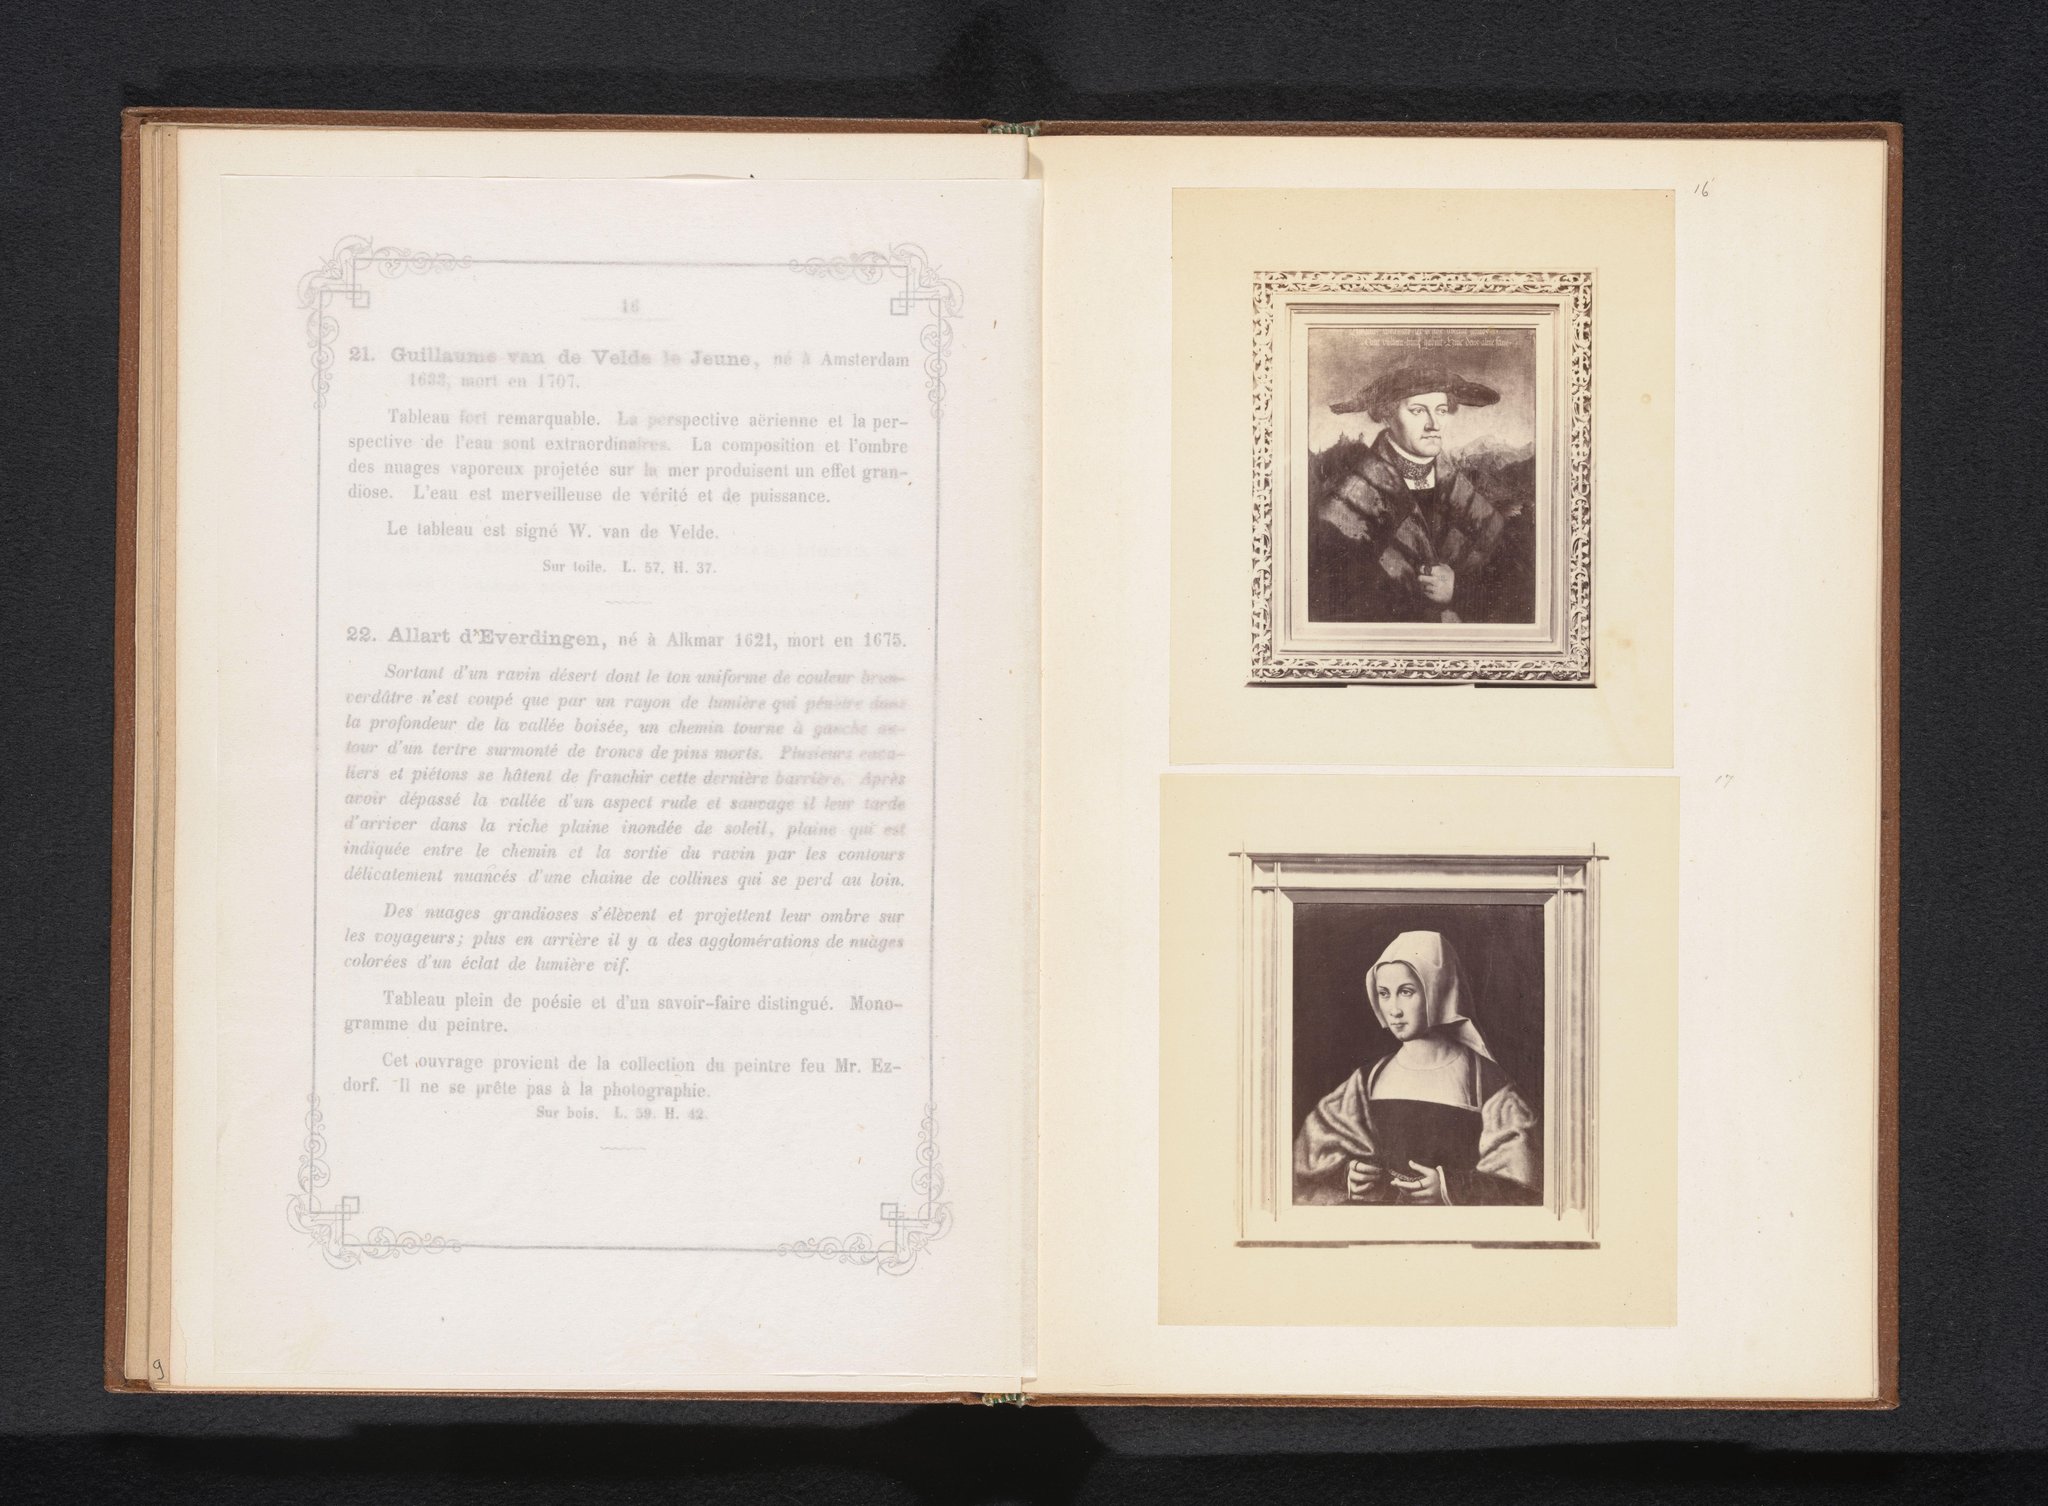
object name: reproduction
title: Fotoreproducties van twee portretten, mogelijk door Hans Holbein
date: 1856-1866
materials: photographic support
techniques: albumen print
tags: picture, painting